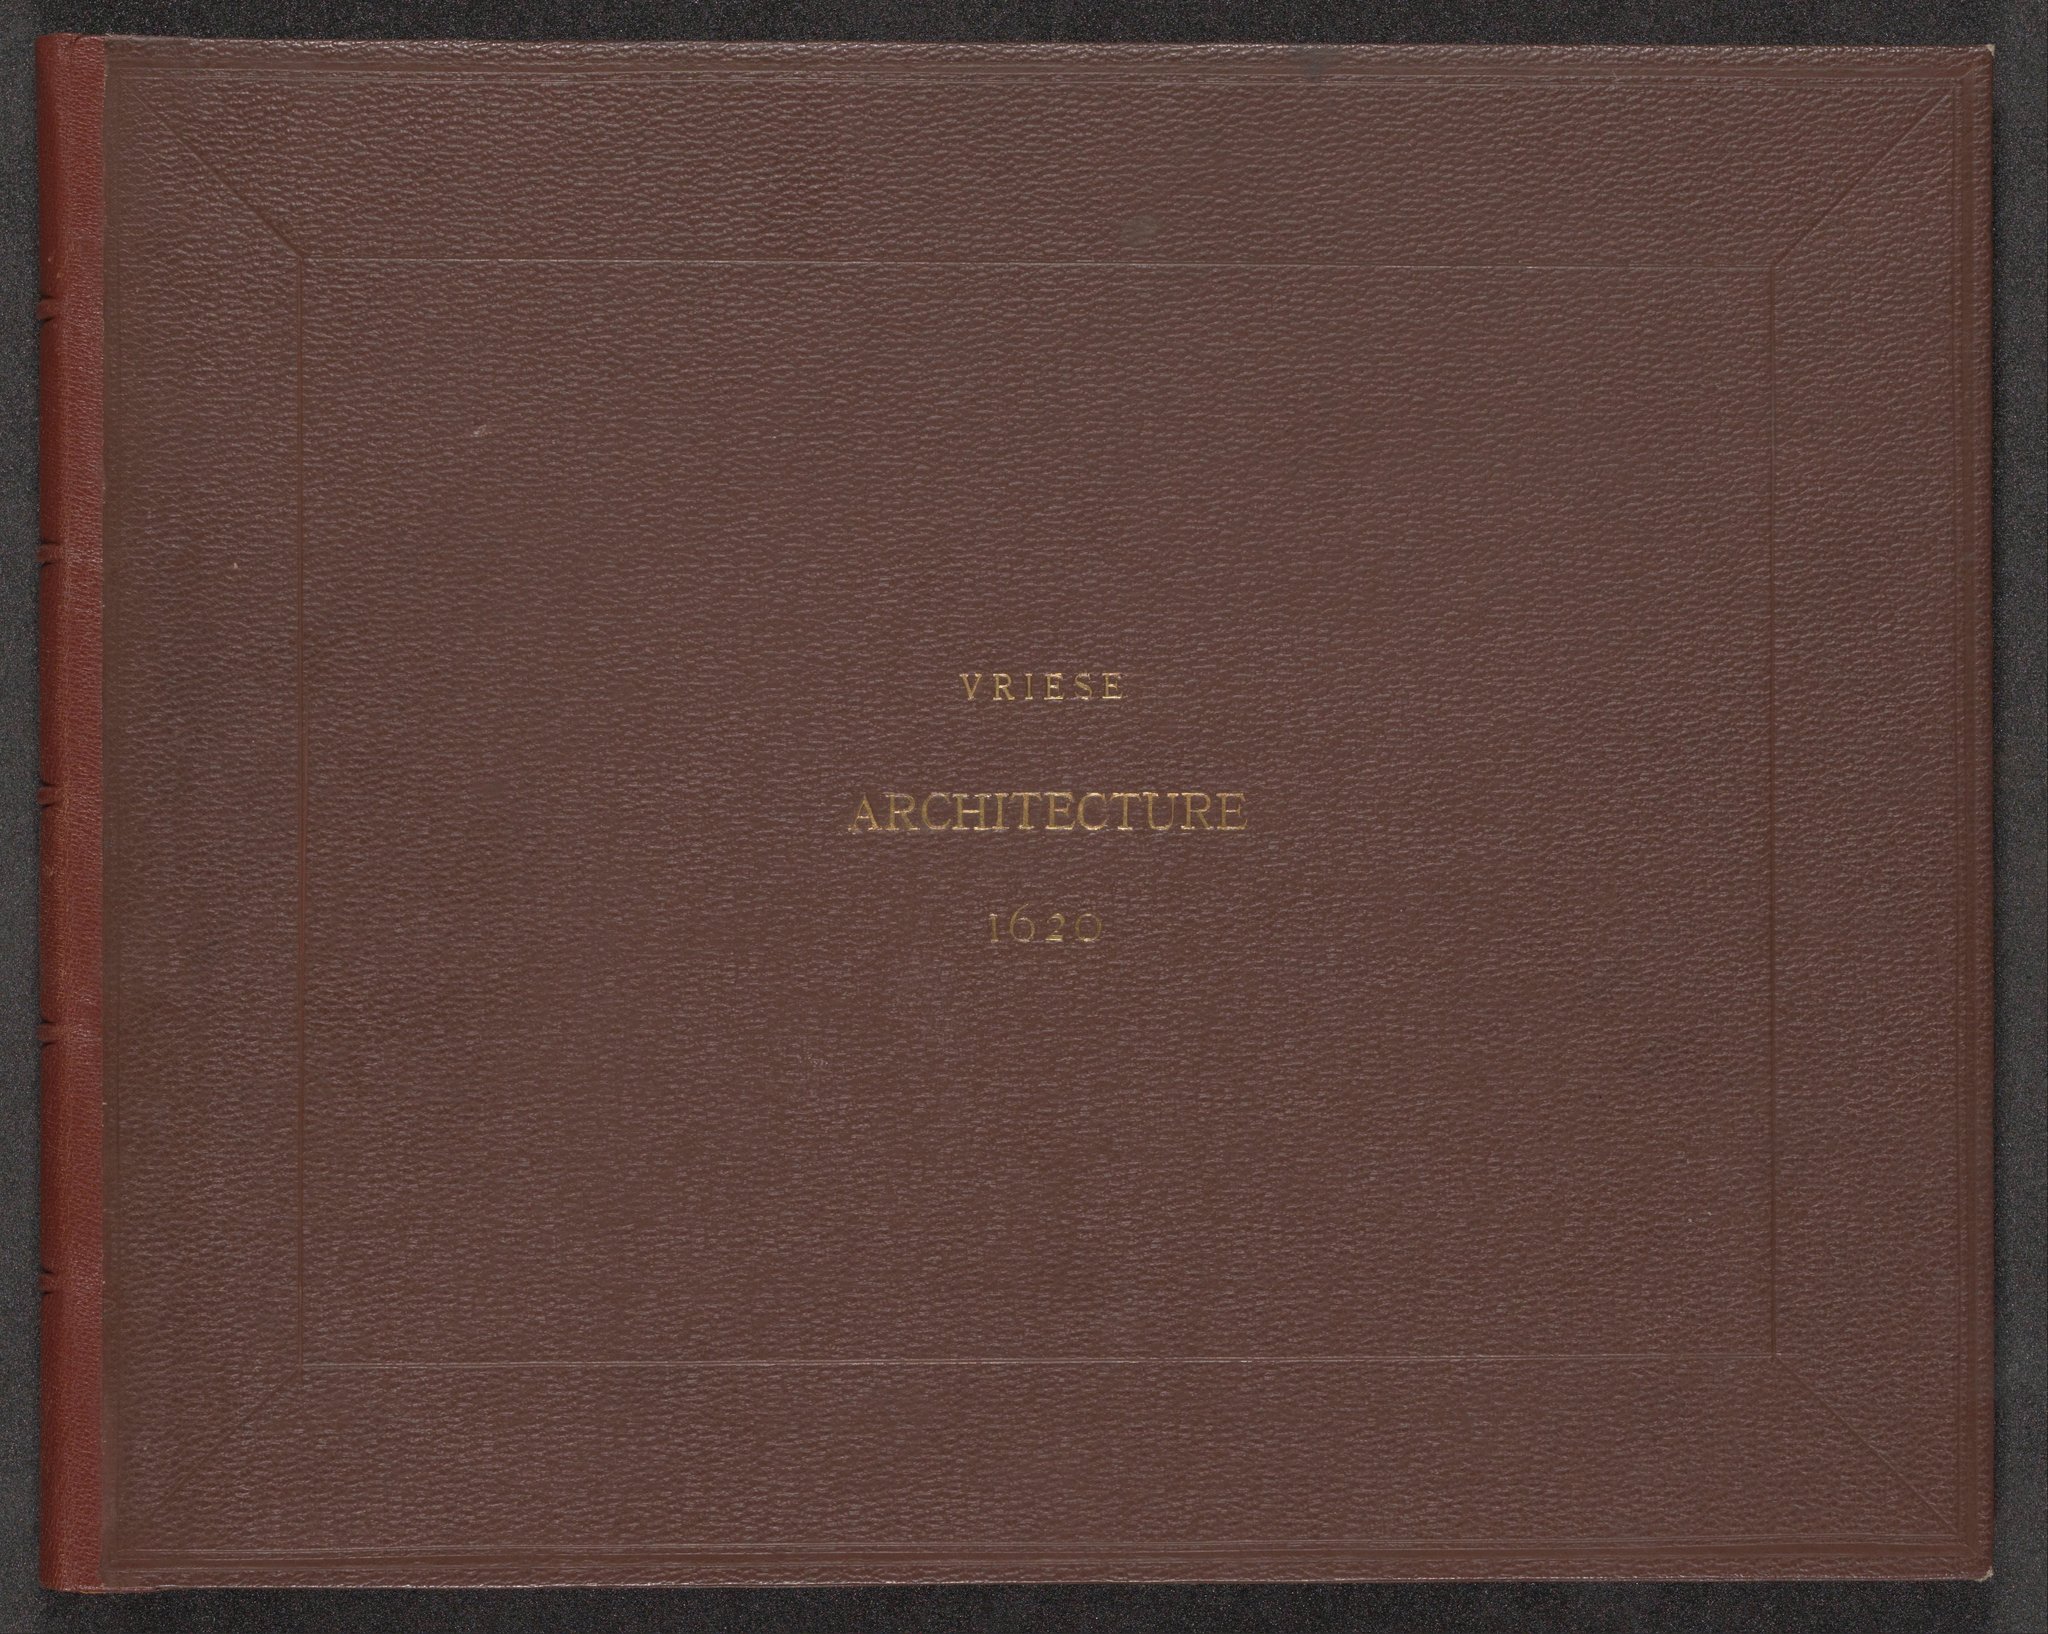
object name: book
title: Album met voorstellingen van de verschillende bouwordes en de toepassing daarvan in architecturale context en interieurs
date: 1620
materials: leather, paper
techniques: bookbinding, engraving, etching, letterpress printing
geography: the hague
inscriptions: collector's mark: ‘Legaat Godefroy No 1043’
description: Album met titelpagina, tekstbladen en 30 prenten op in totaal 39 albumbladen. De albumbladen zijn genummerd: A t/m Z en AA t/m OO. Het album bevat de serie Architectura over de vijf verschillende bouwordes en de toepassing daarvan in architecturale context en interieurs. Franse editie. Voor- en achterin een schutblad.